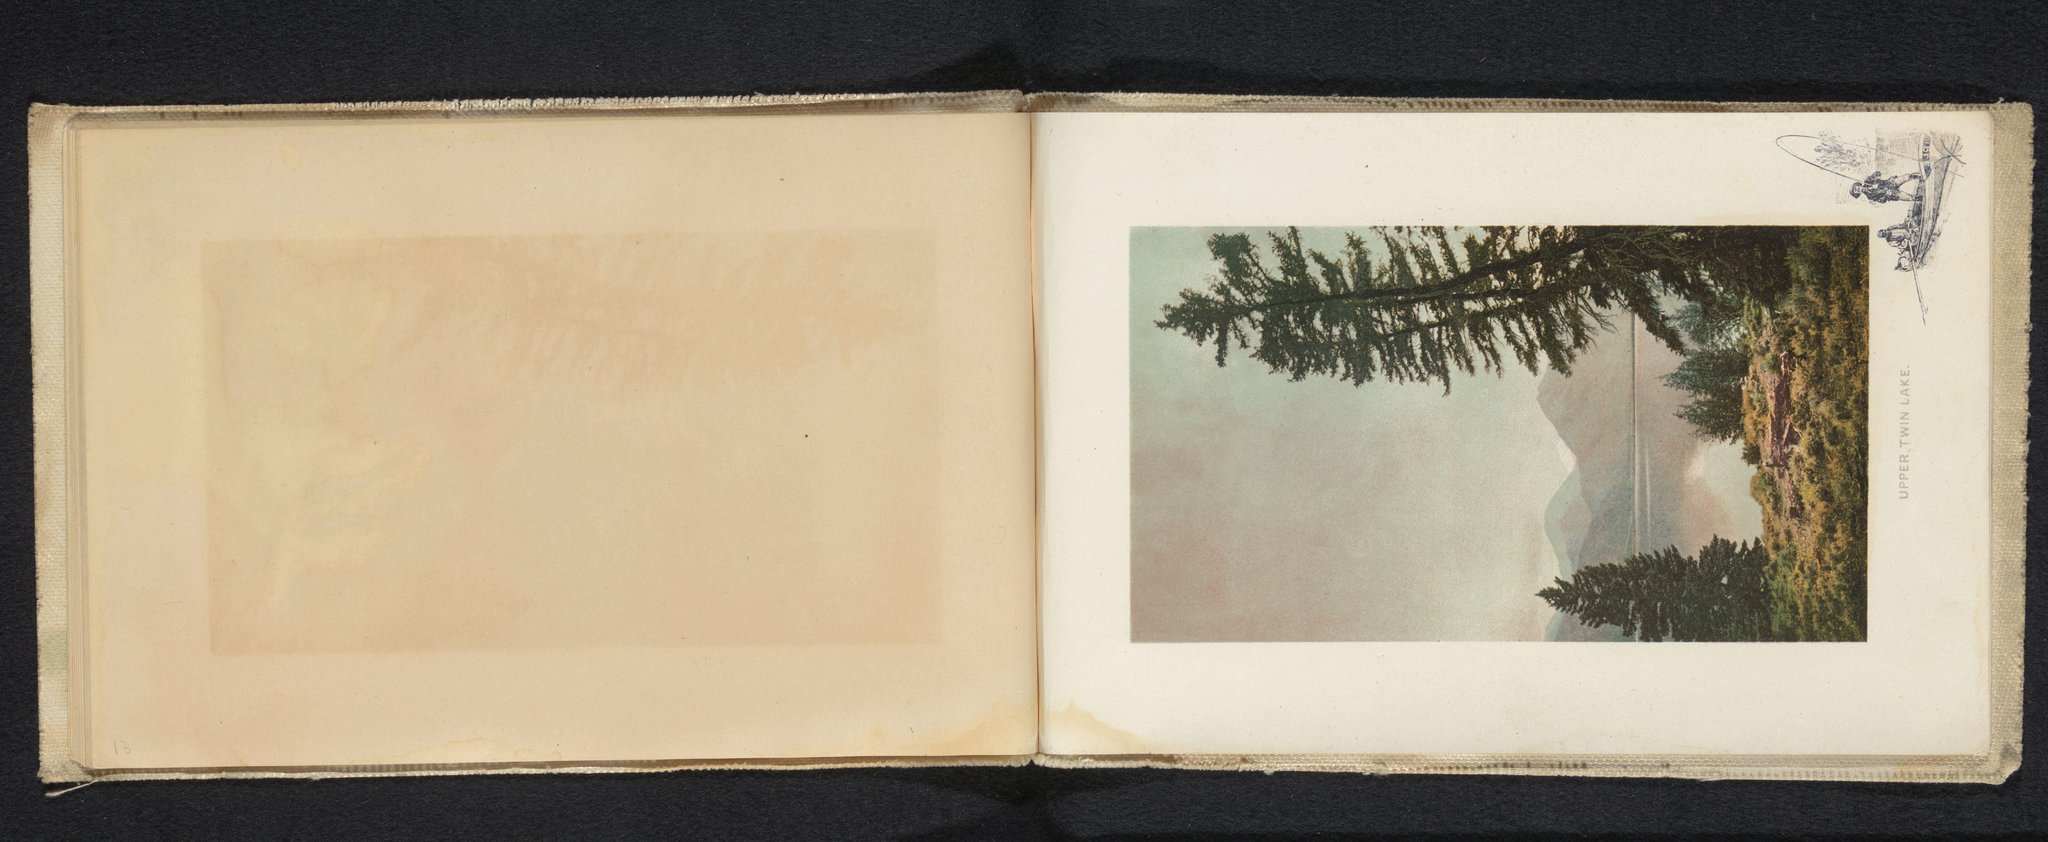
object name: photomechanical print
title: Upper Twin Lake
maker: Anonymous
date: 1894-1899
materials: paper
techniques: lithograph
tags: lake